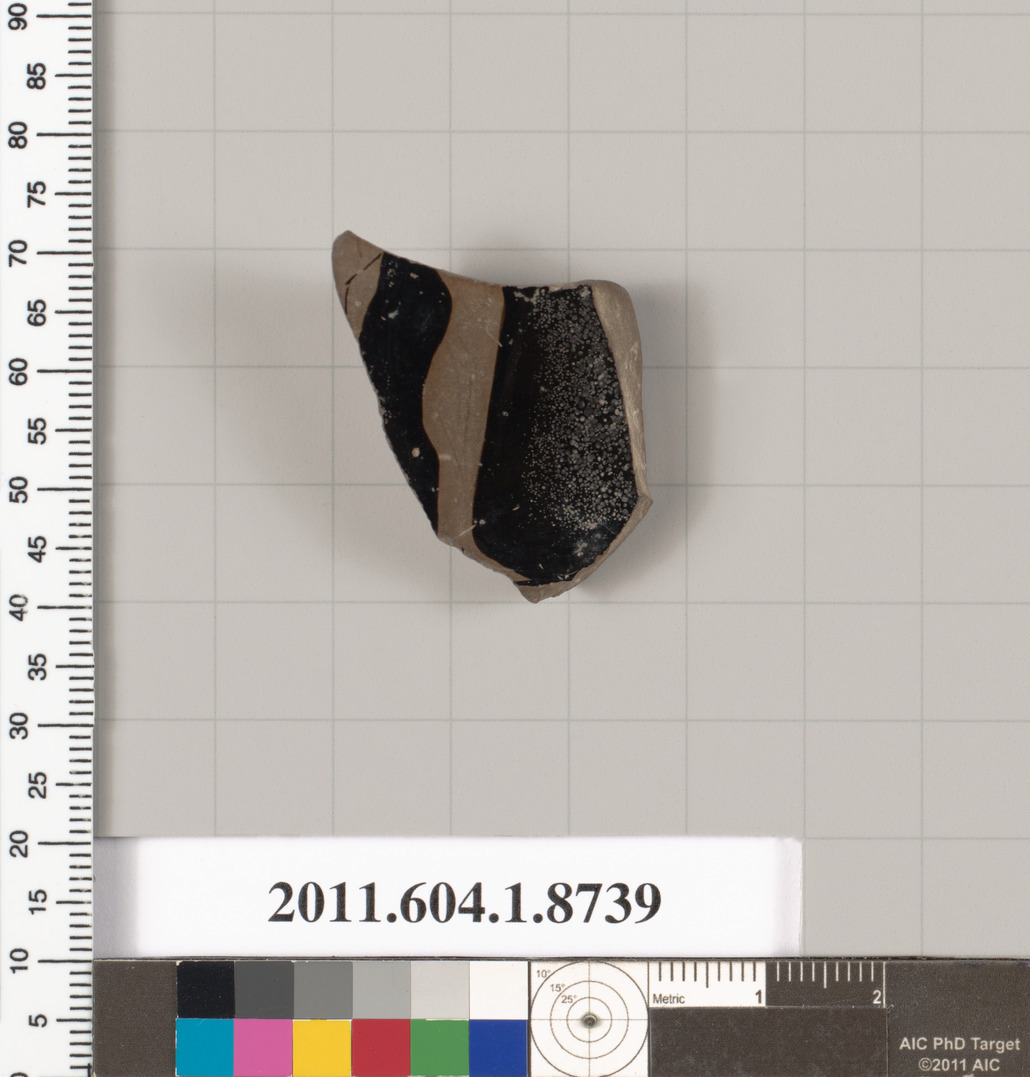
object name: kylix fragment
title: Terracotta fragment of a stemless cup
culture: greek, attic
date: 475-451 BCE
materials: terracotta